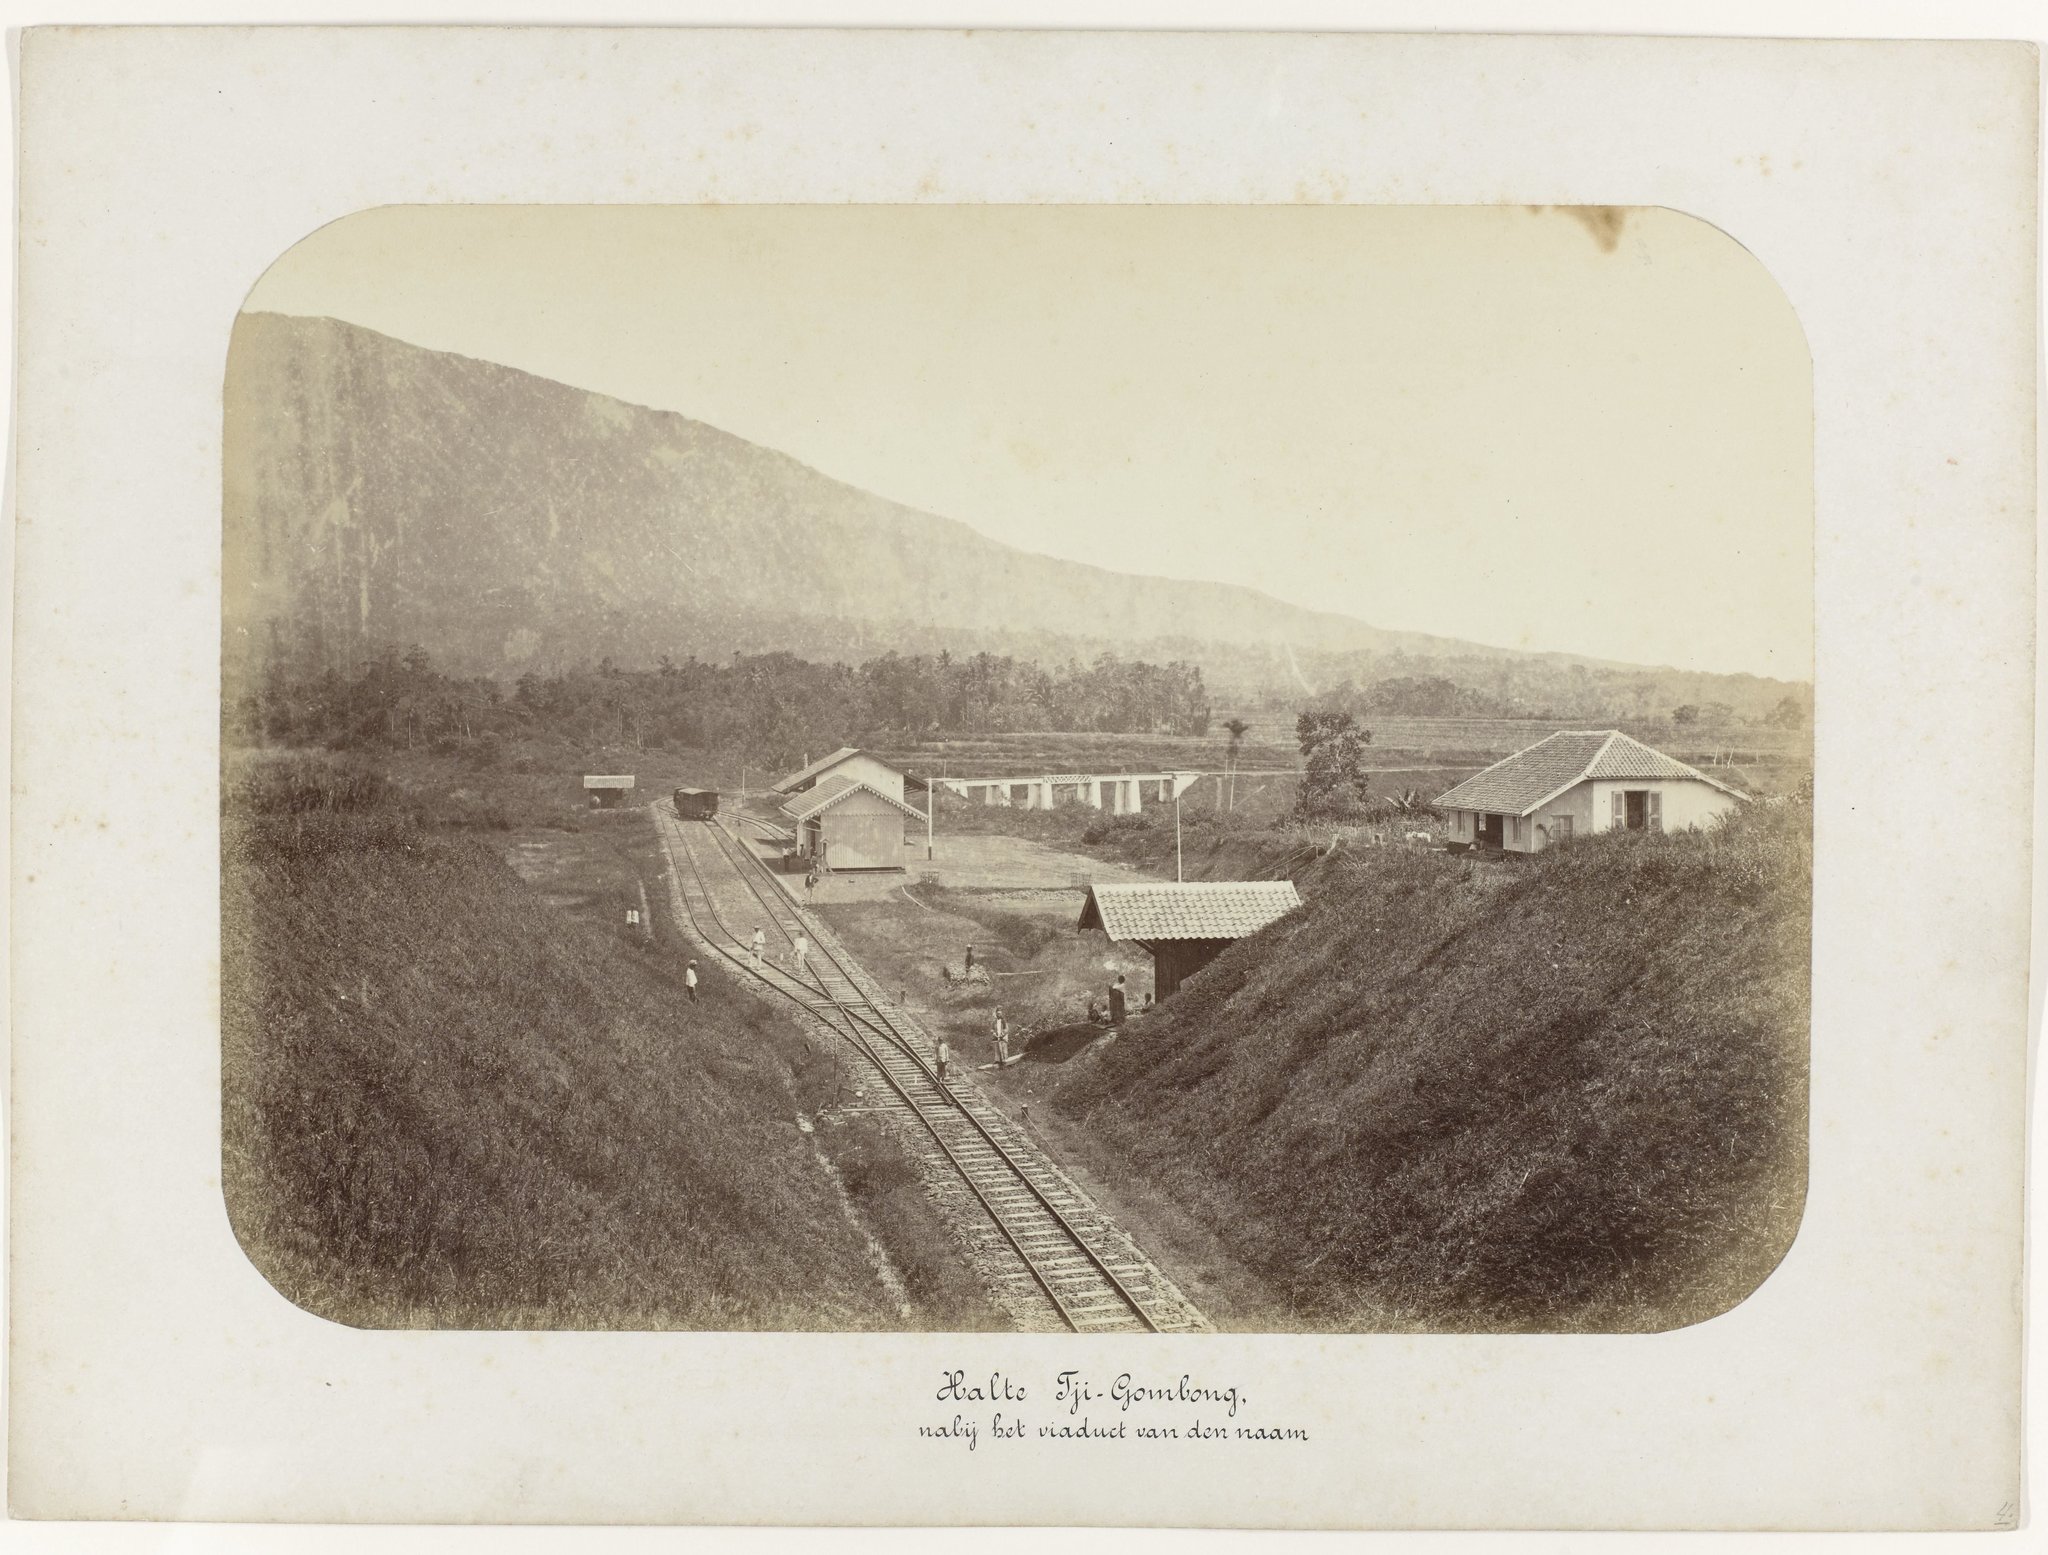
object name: photograph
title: Staatsspoorwegen op Java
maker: Anonymous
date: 1880-1888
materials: photographic support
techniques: albumen print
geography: java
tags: java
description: De spoorweg met de halte Tji-Gombong, in de verte bergen. Onderdeel van een groep van 62 foto's in een doos met het opschrift "Staatsspoorwegen op Java" uit 1888.